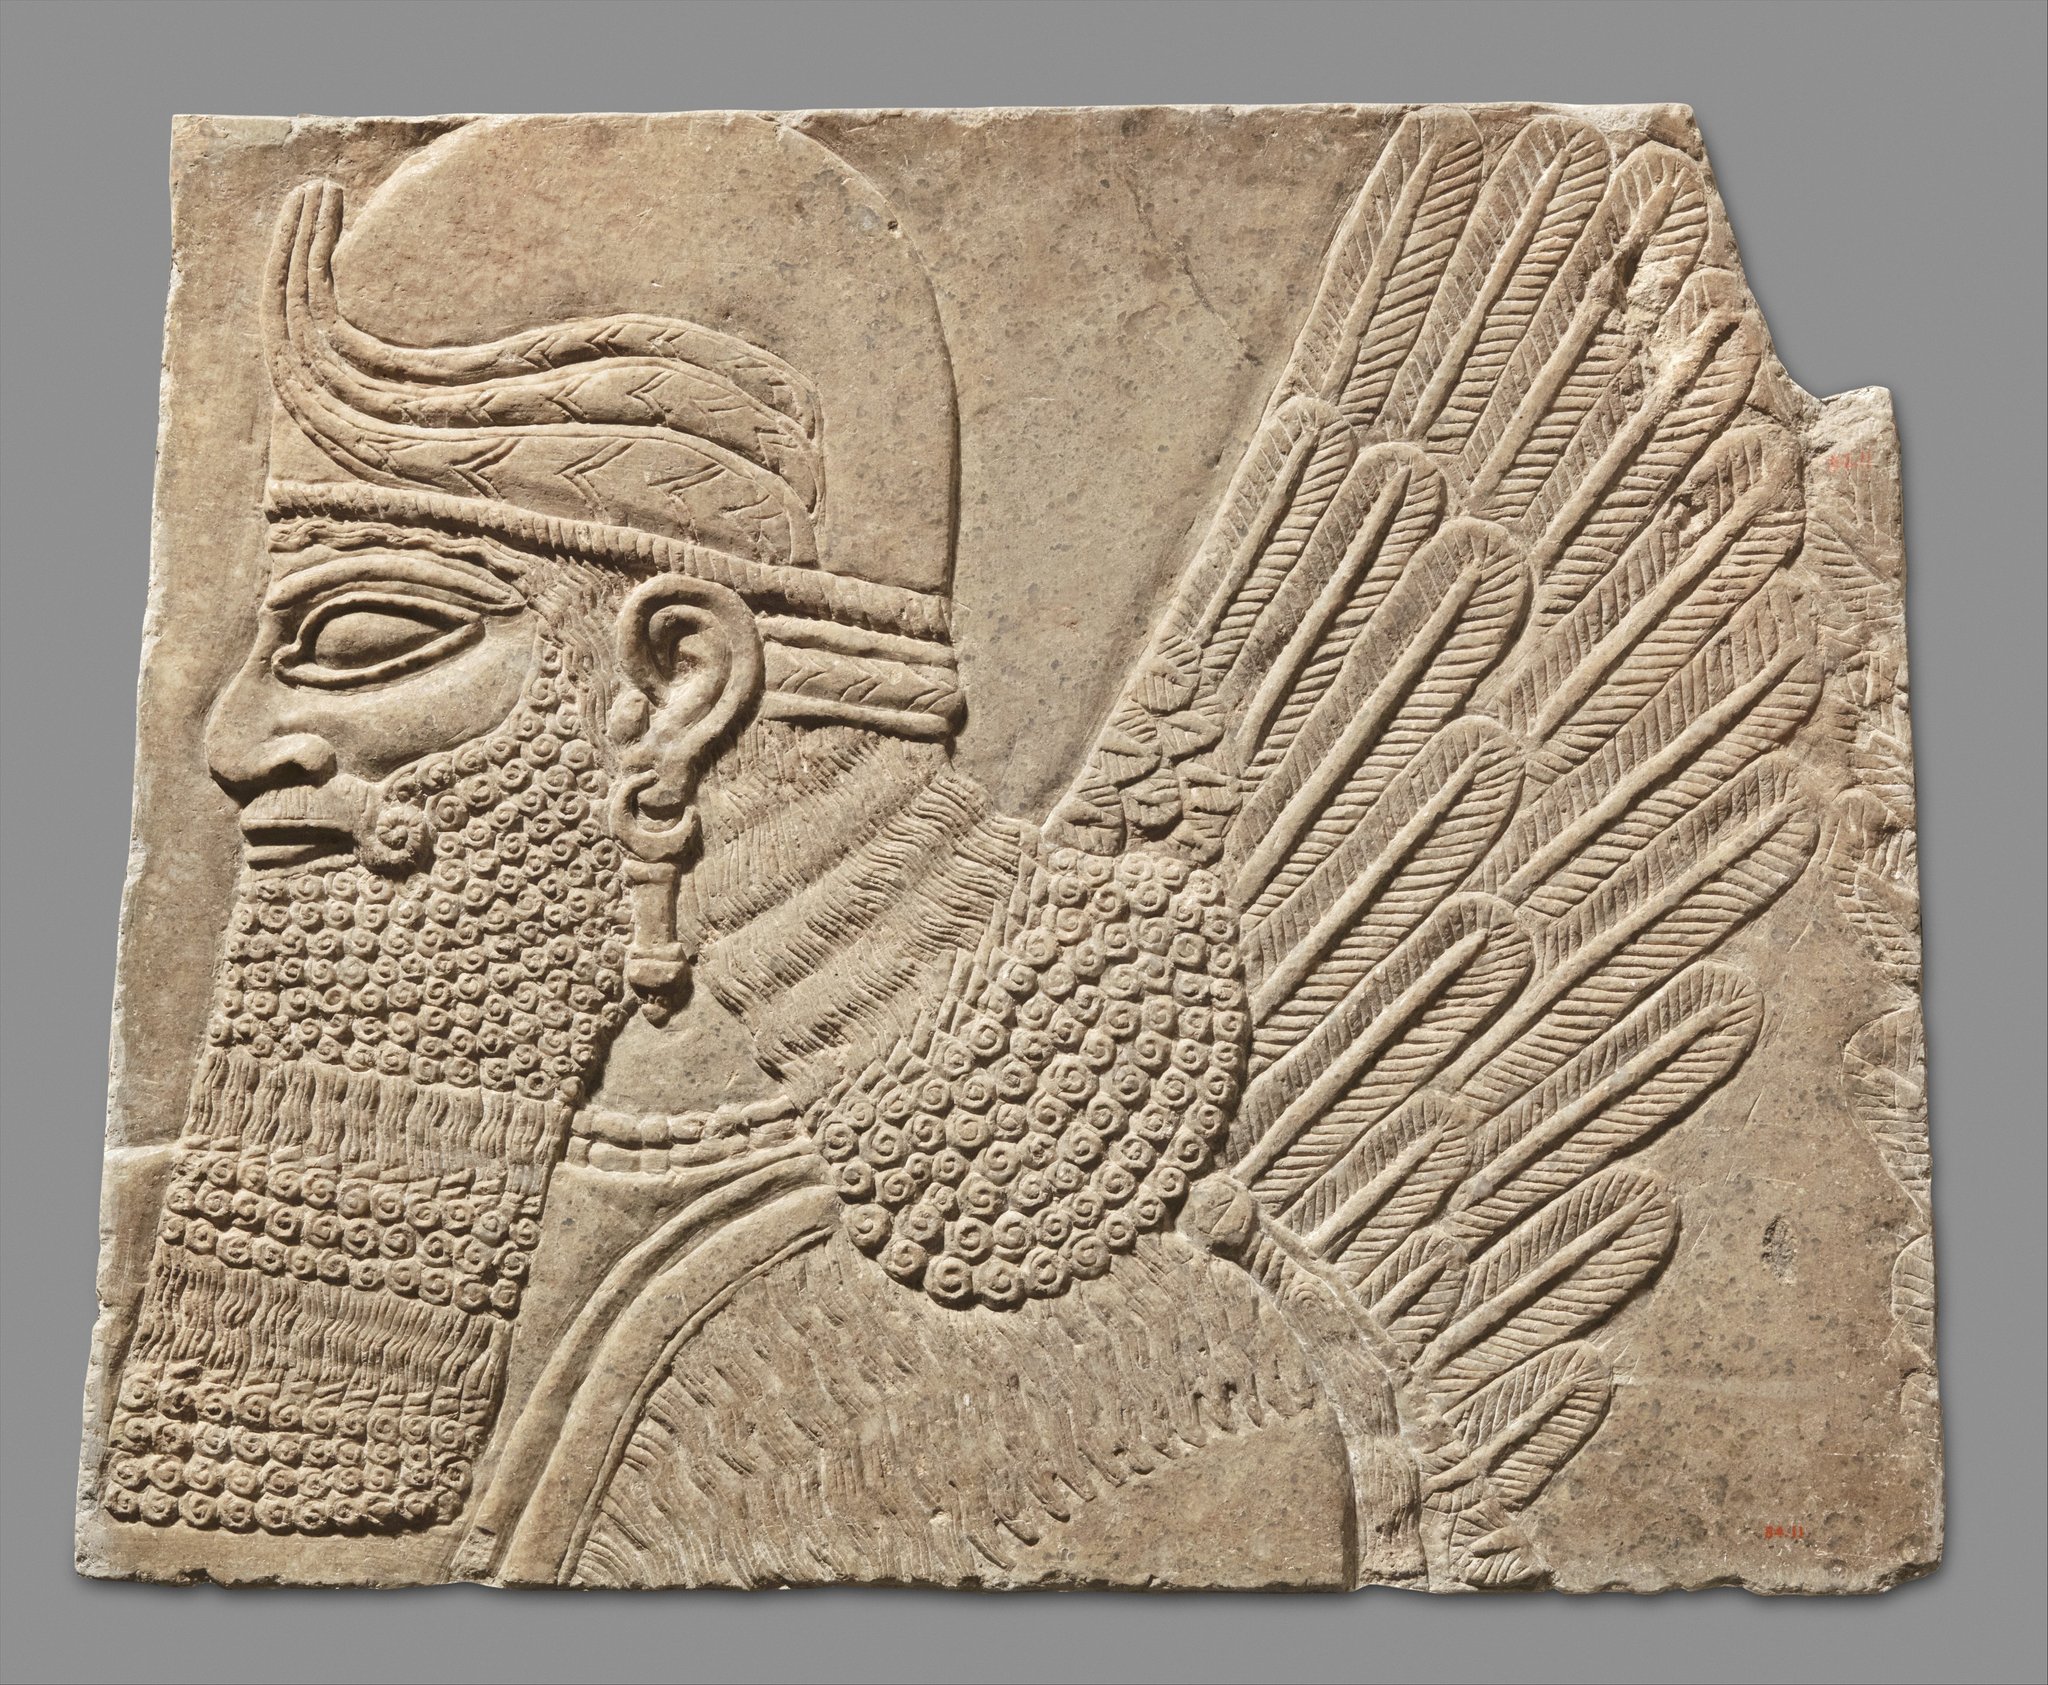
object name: relief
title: Relief panel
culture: assyrian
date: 883-859 BCE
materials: alabaster, gypsum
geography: mesopotamia